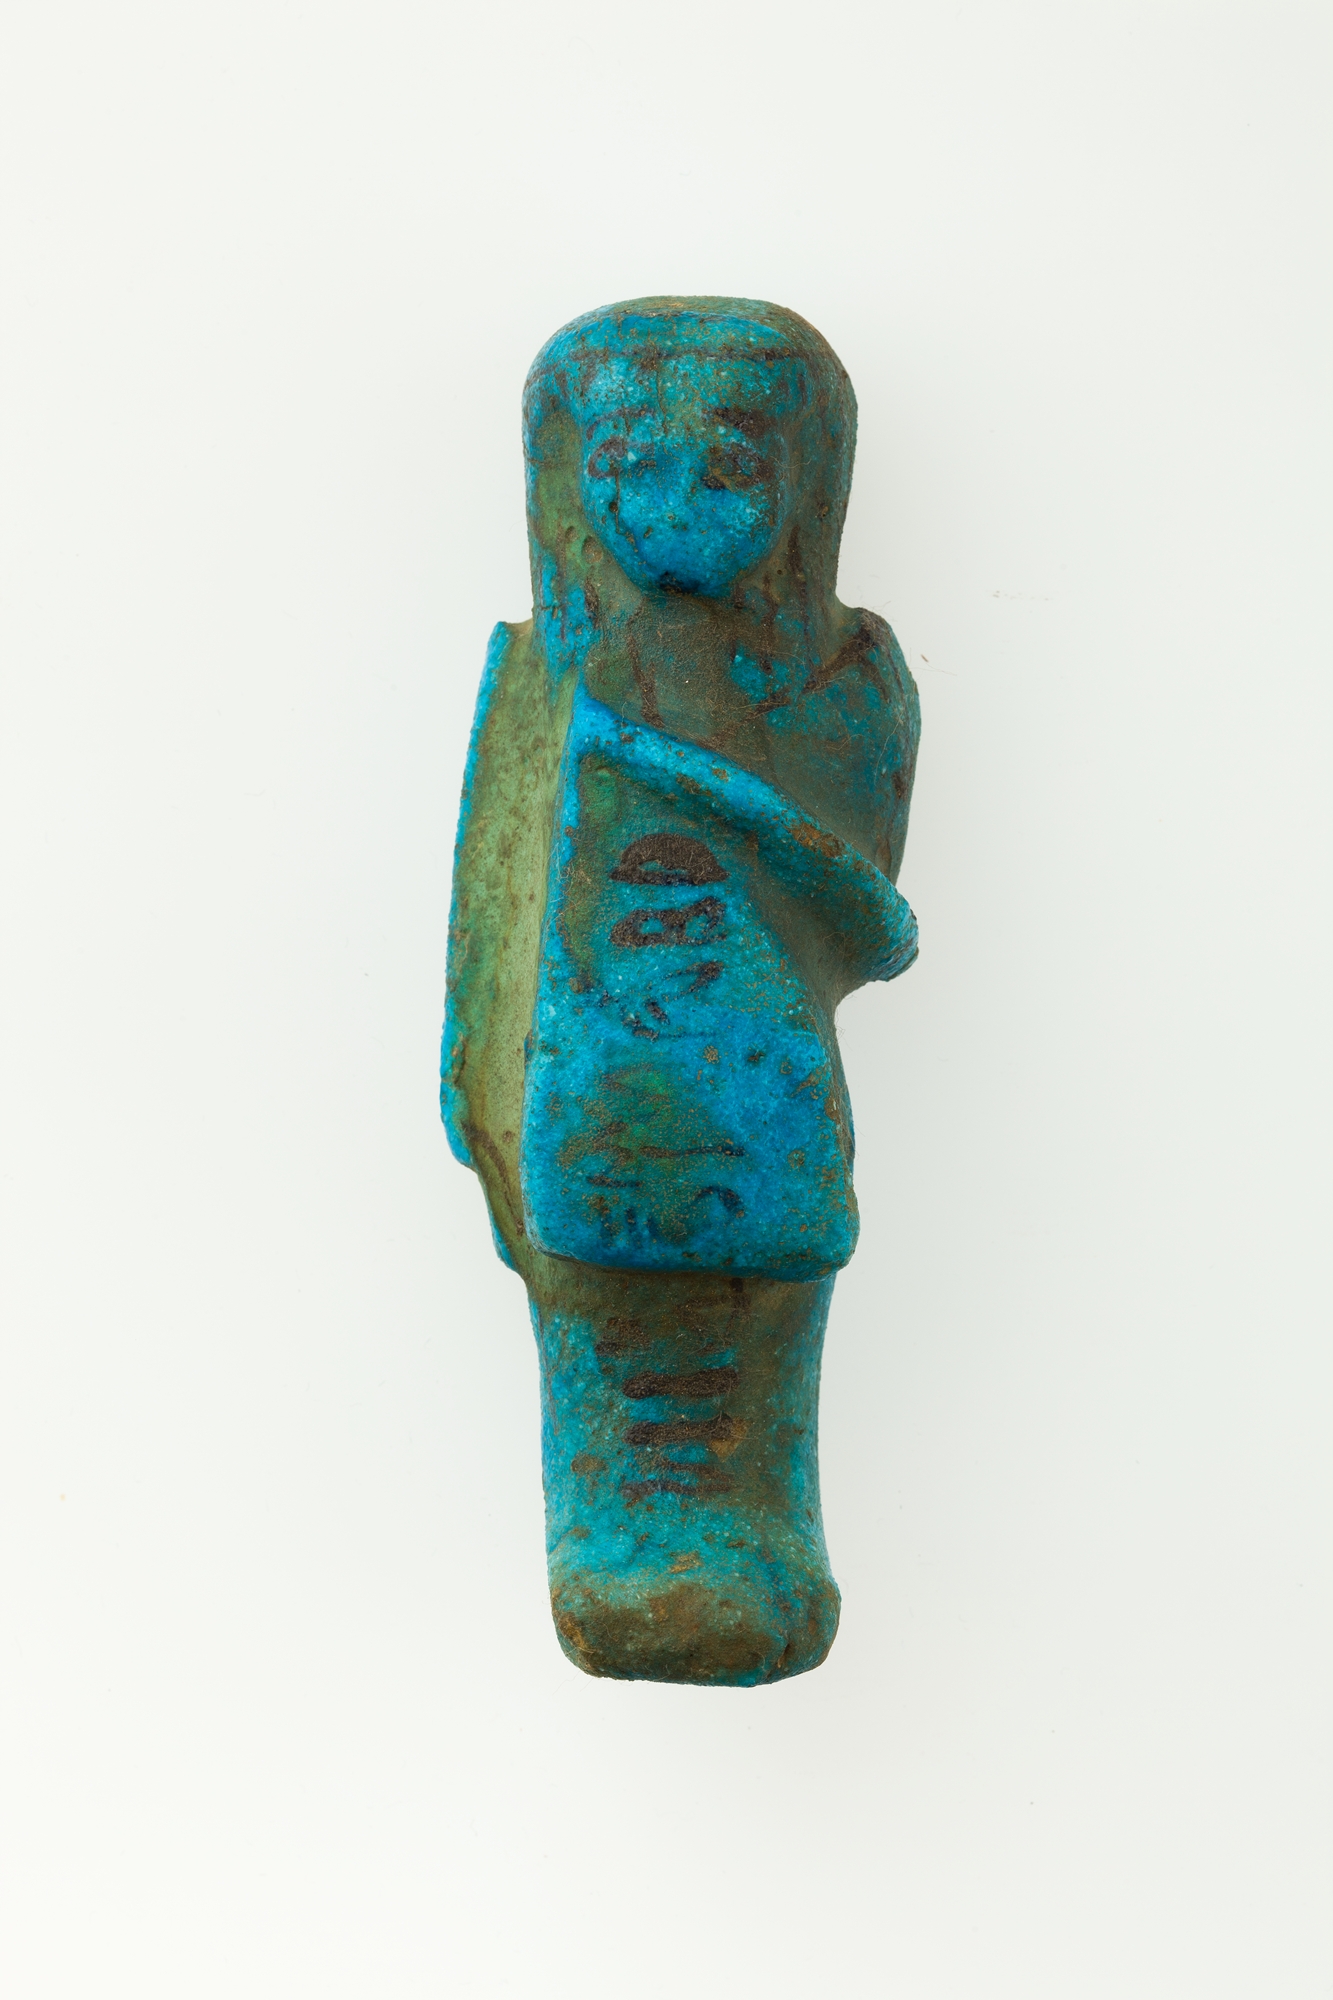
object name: shabti, henettawy c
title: Overseer Shabti of Henettawy (C), Daughter of Isetemkheb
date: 990-970 BCE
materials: faience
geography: egypt